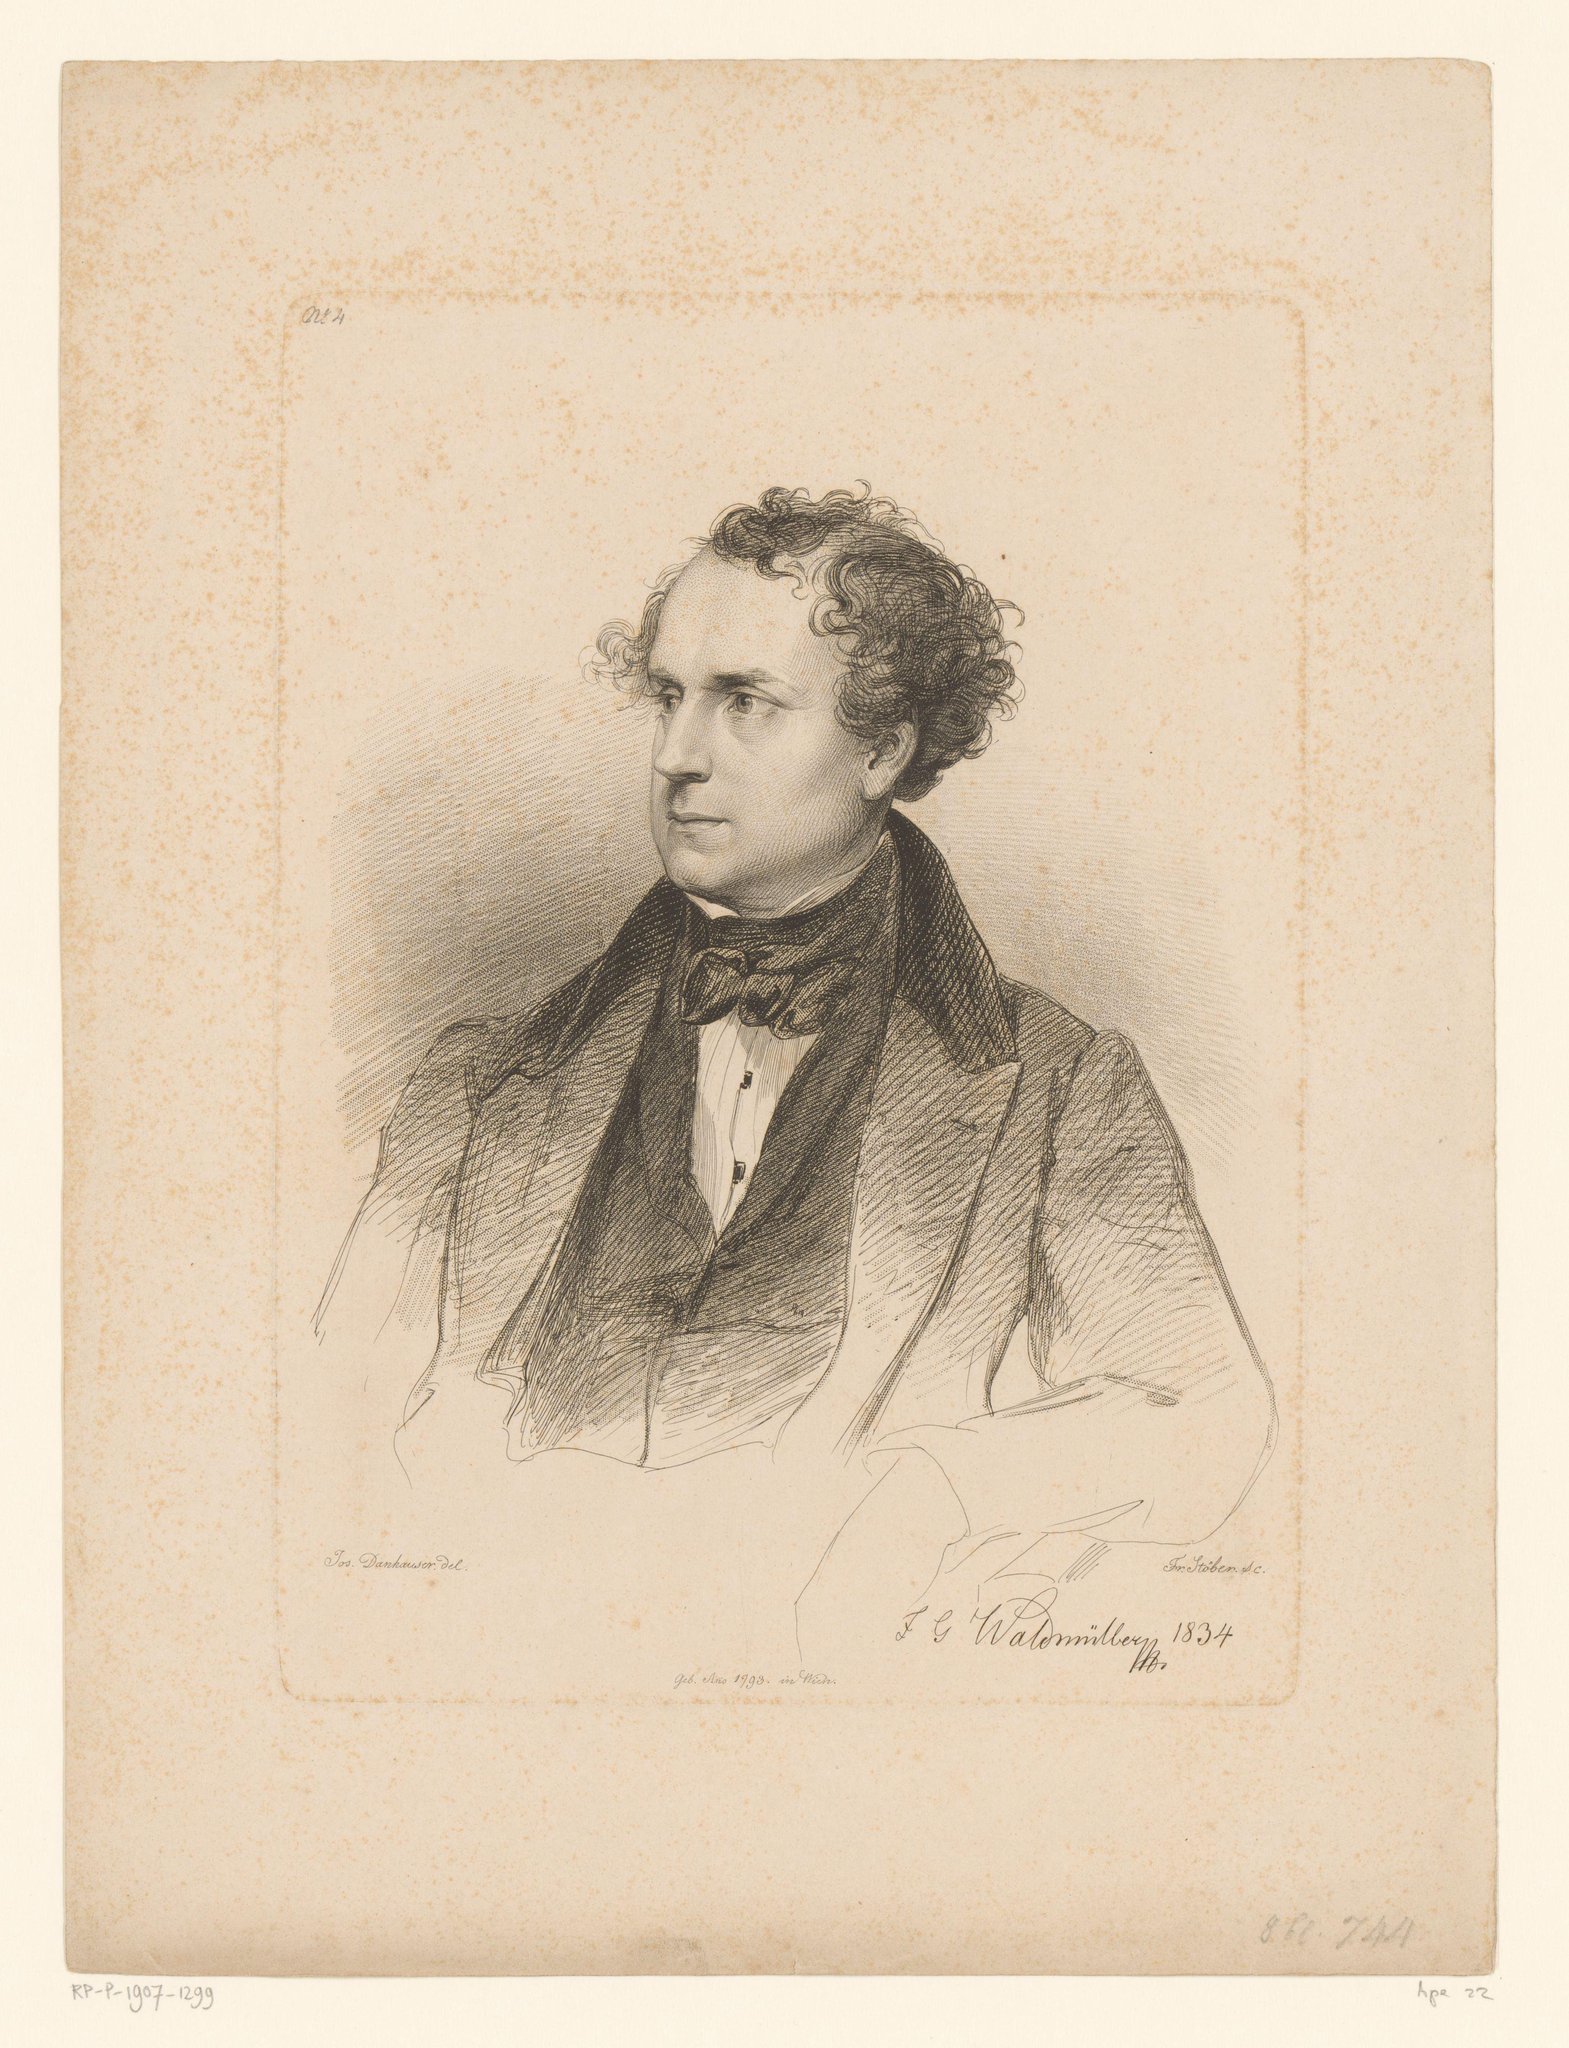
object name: print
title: Portret van Ferdinand Georg Waldmüller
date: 1834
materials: paper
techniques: engraving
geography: vienna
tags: vienna, painter, historical persons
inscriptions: collector's mark: Lugt 2228